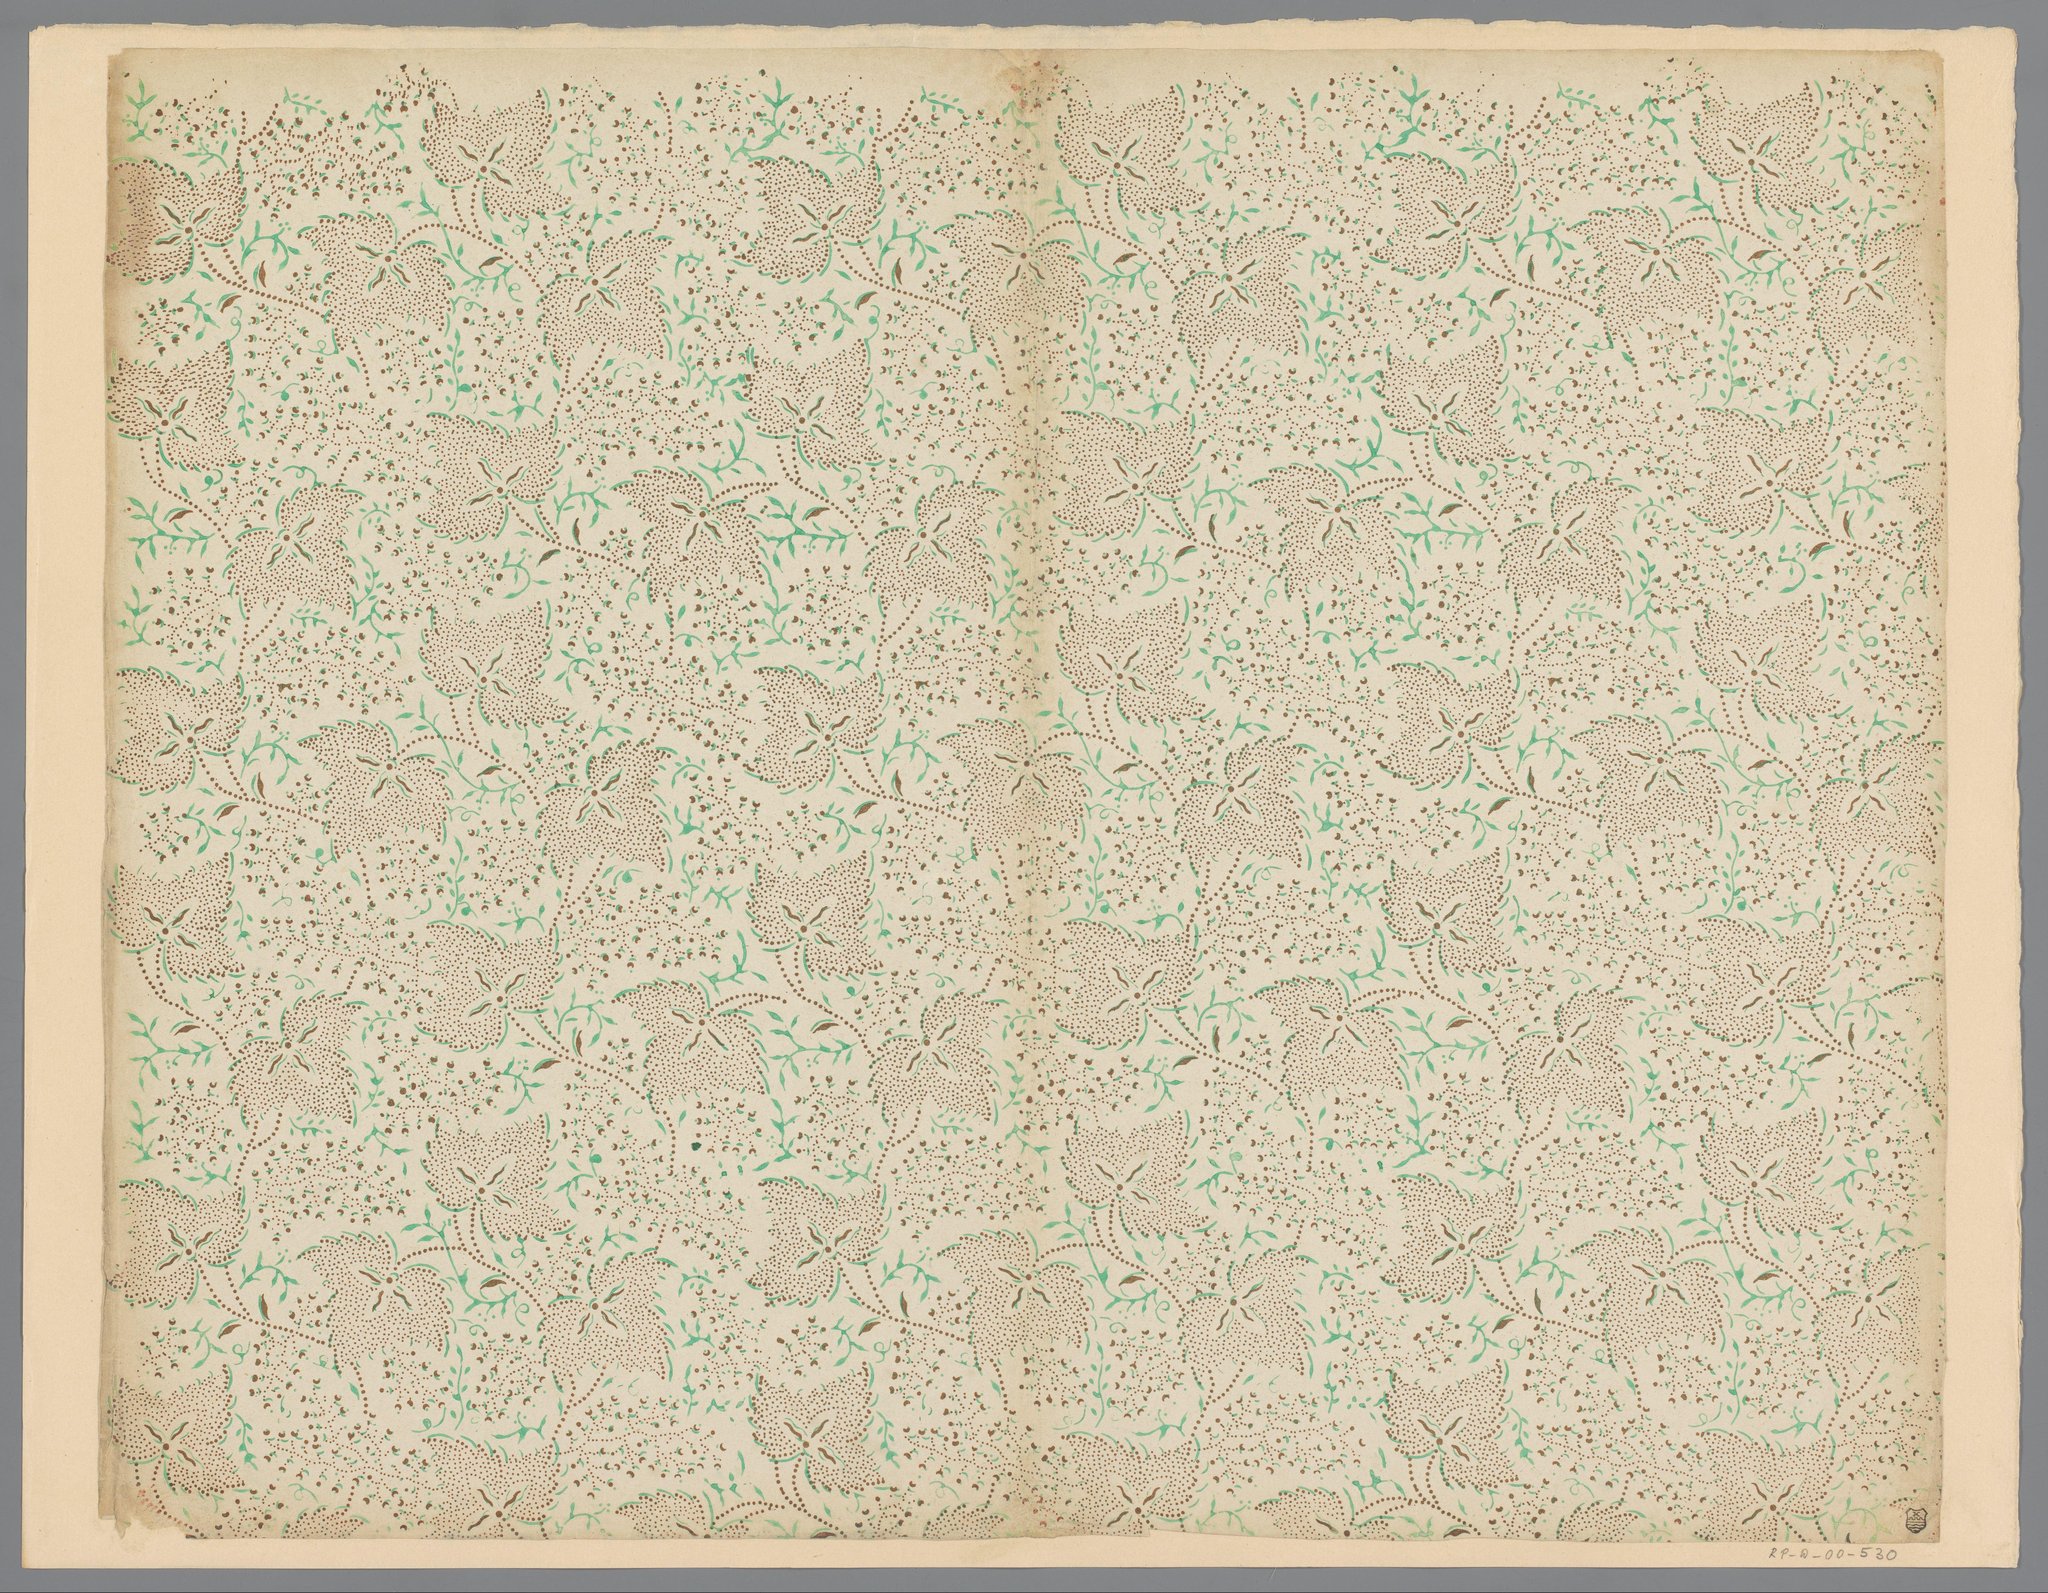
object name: printed paper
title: Blad met strooipatroon van bladmotief en ranken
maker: Anonymous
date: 1800-1900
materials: paint, paper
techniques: printing block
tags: ornament derived from plant forms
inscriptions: collector's mark: Lugt 2760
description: Blad met strooipatroon van bladmotief in punten over ranken.